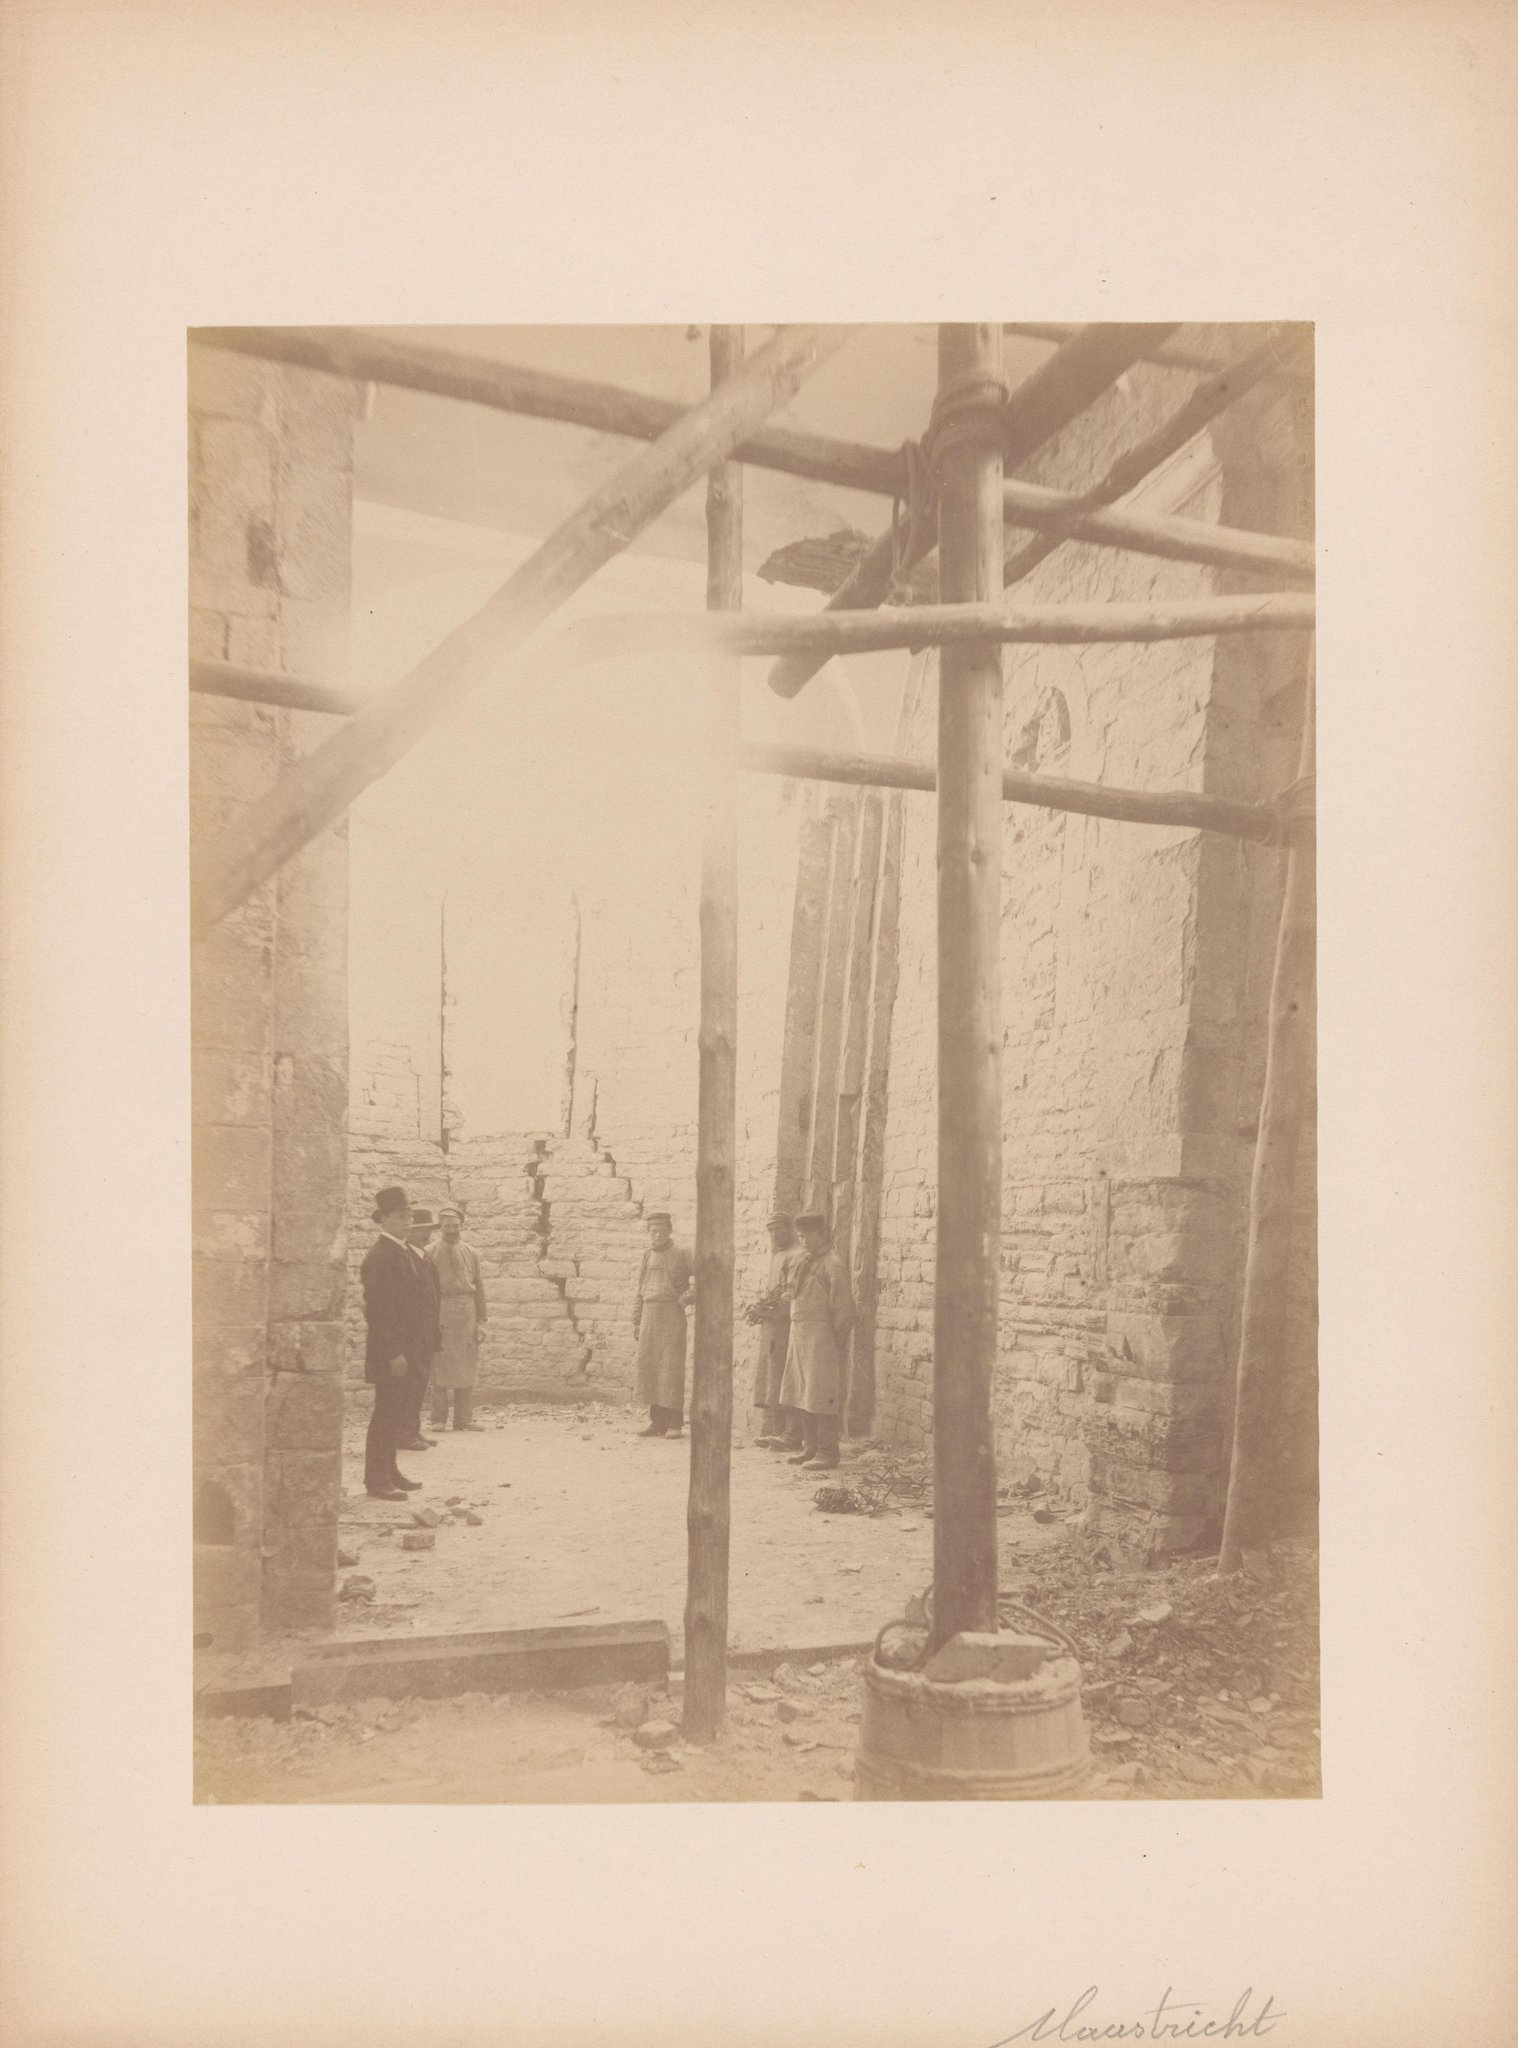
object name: photograph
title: Restauratie van de kapel in het zuidtransept van de Onze-Lieve-Vrouwebasiliek te Maastricht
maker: anoniem (monumentenzorg)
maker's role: fotograaf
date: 1890-1915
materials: cardboard, photographic support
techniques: albumen print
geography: onze-lieve-vrouwe-basiliek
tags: parts of church interior: chapel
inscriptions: annotation: ‘Maastricht’, annotation: ‘O.L.V. kerk Maastricht/ restauratie zuidtransept/ aanzicht in de kapel oostmuur beneden’